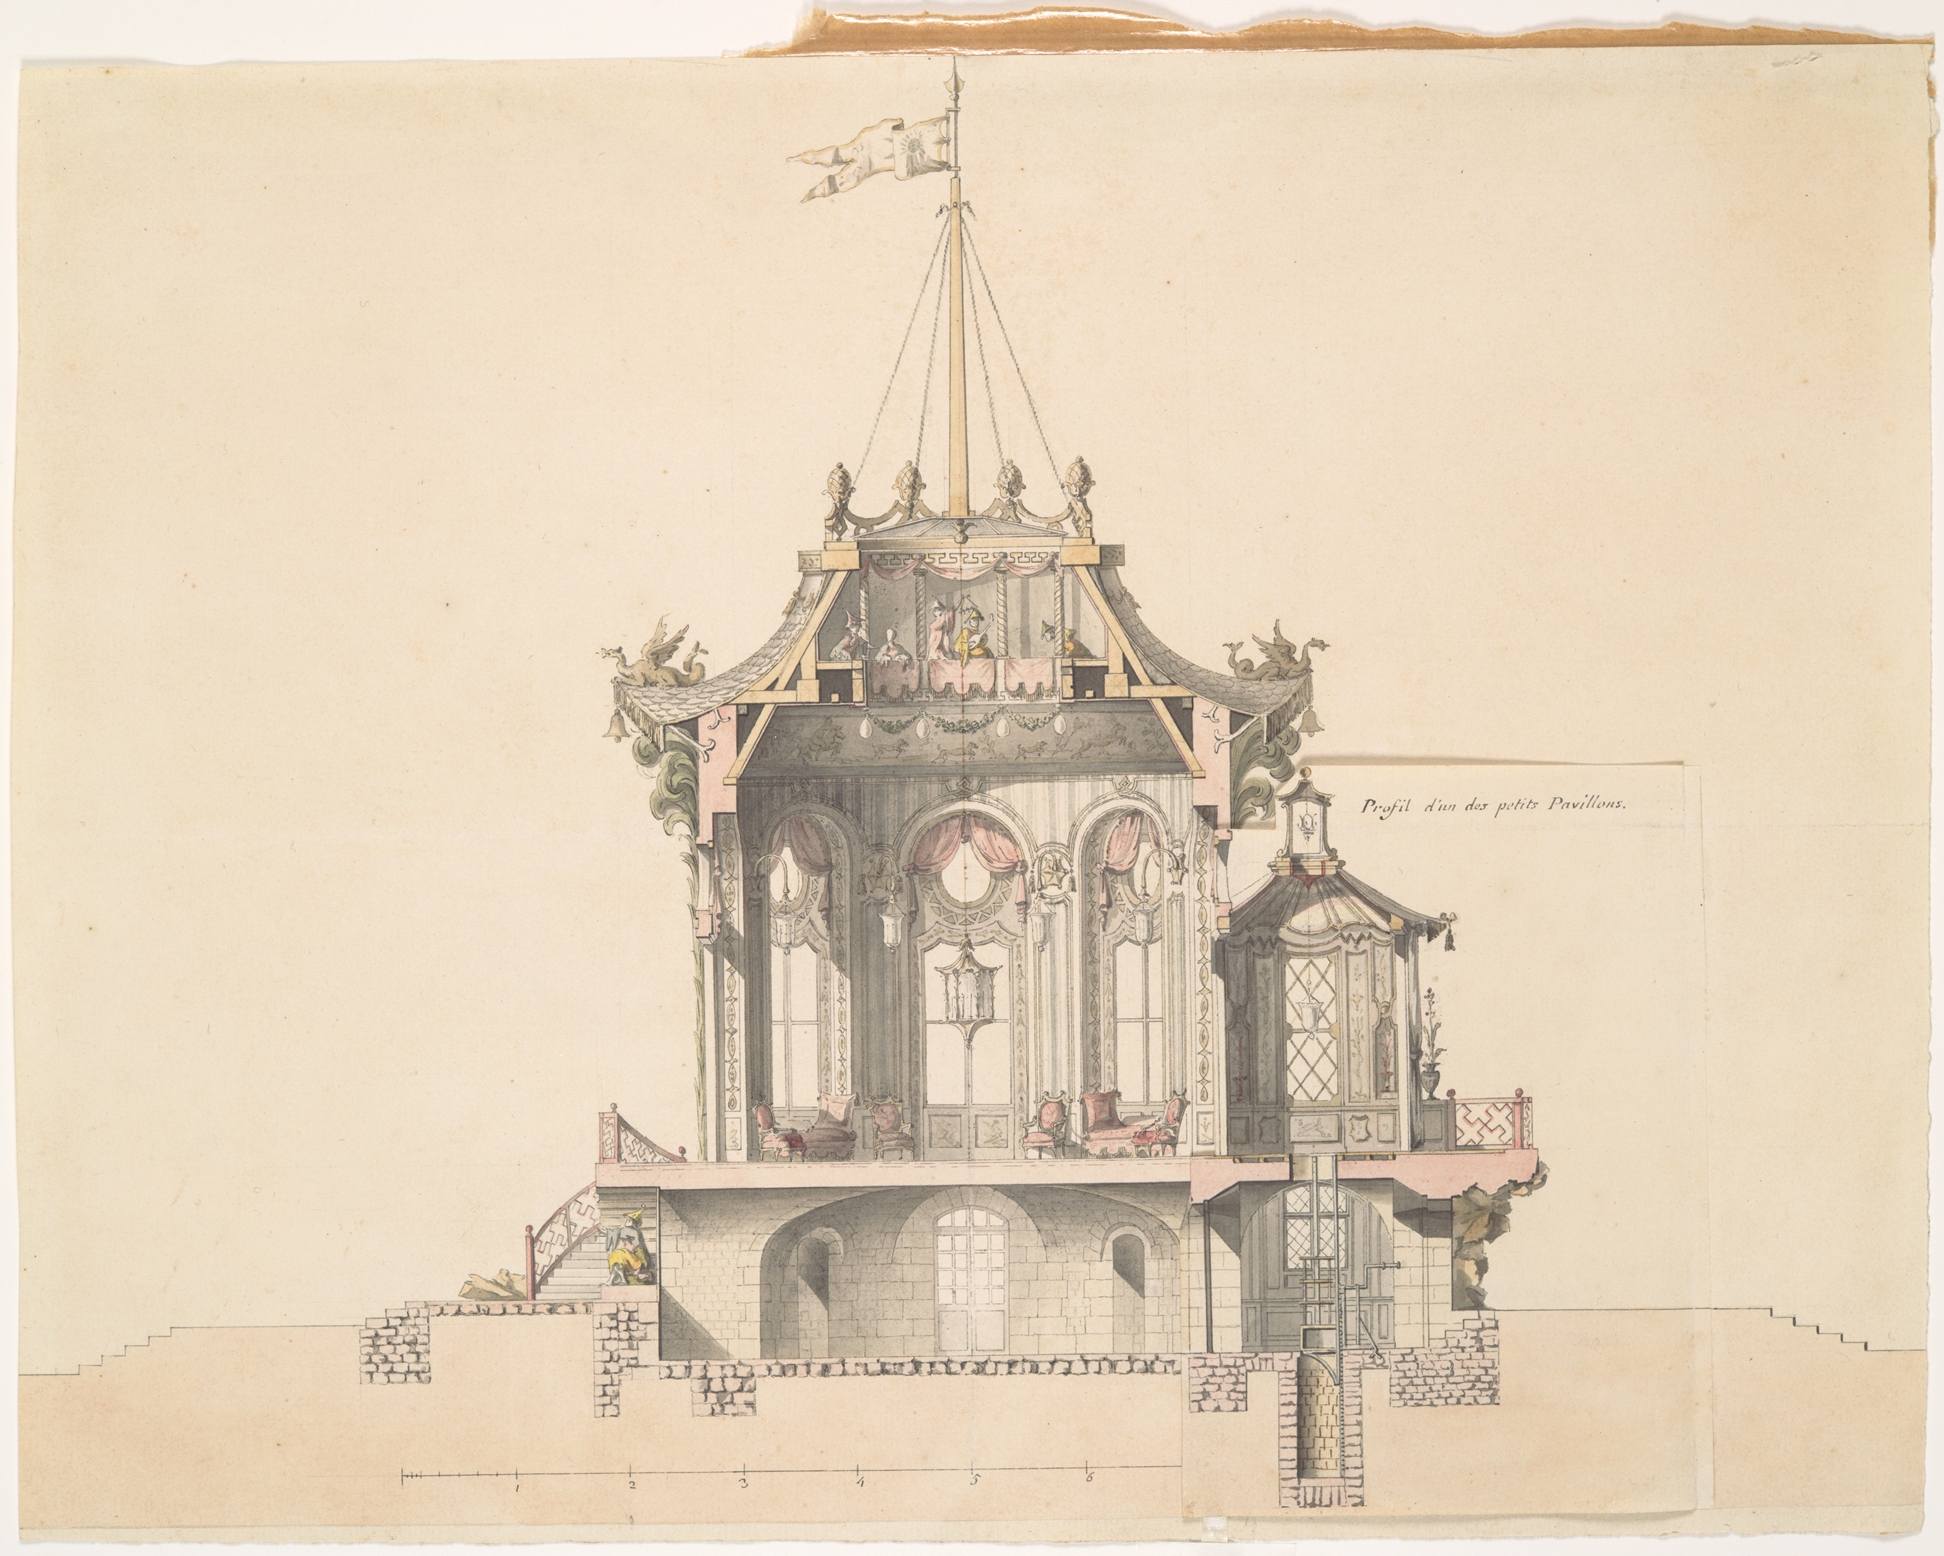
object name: drawing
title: Project for a Chinese Pavillion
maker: michel barthelemy hazon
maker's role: artist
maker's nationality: french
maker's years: 1722-1818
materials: graphite, ink, paper, watercolor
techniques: pen, drawing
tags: buildings,flags